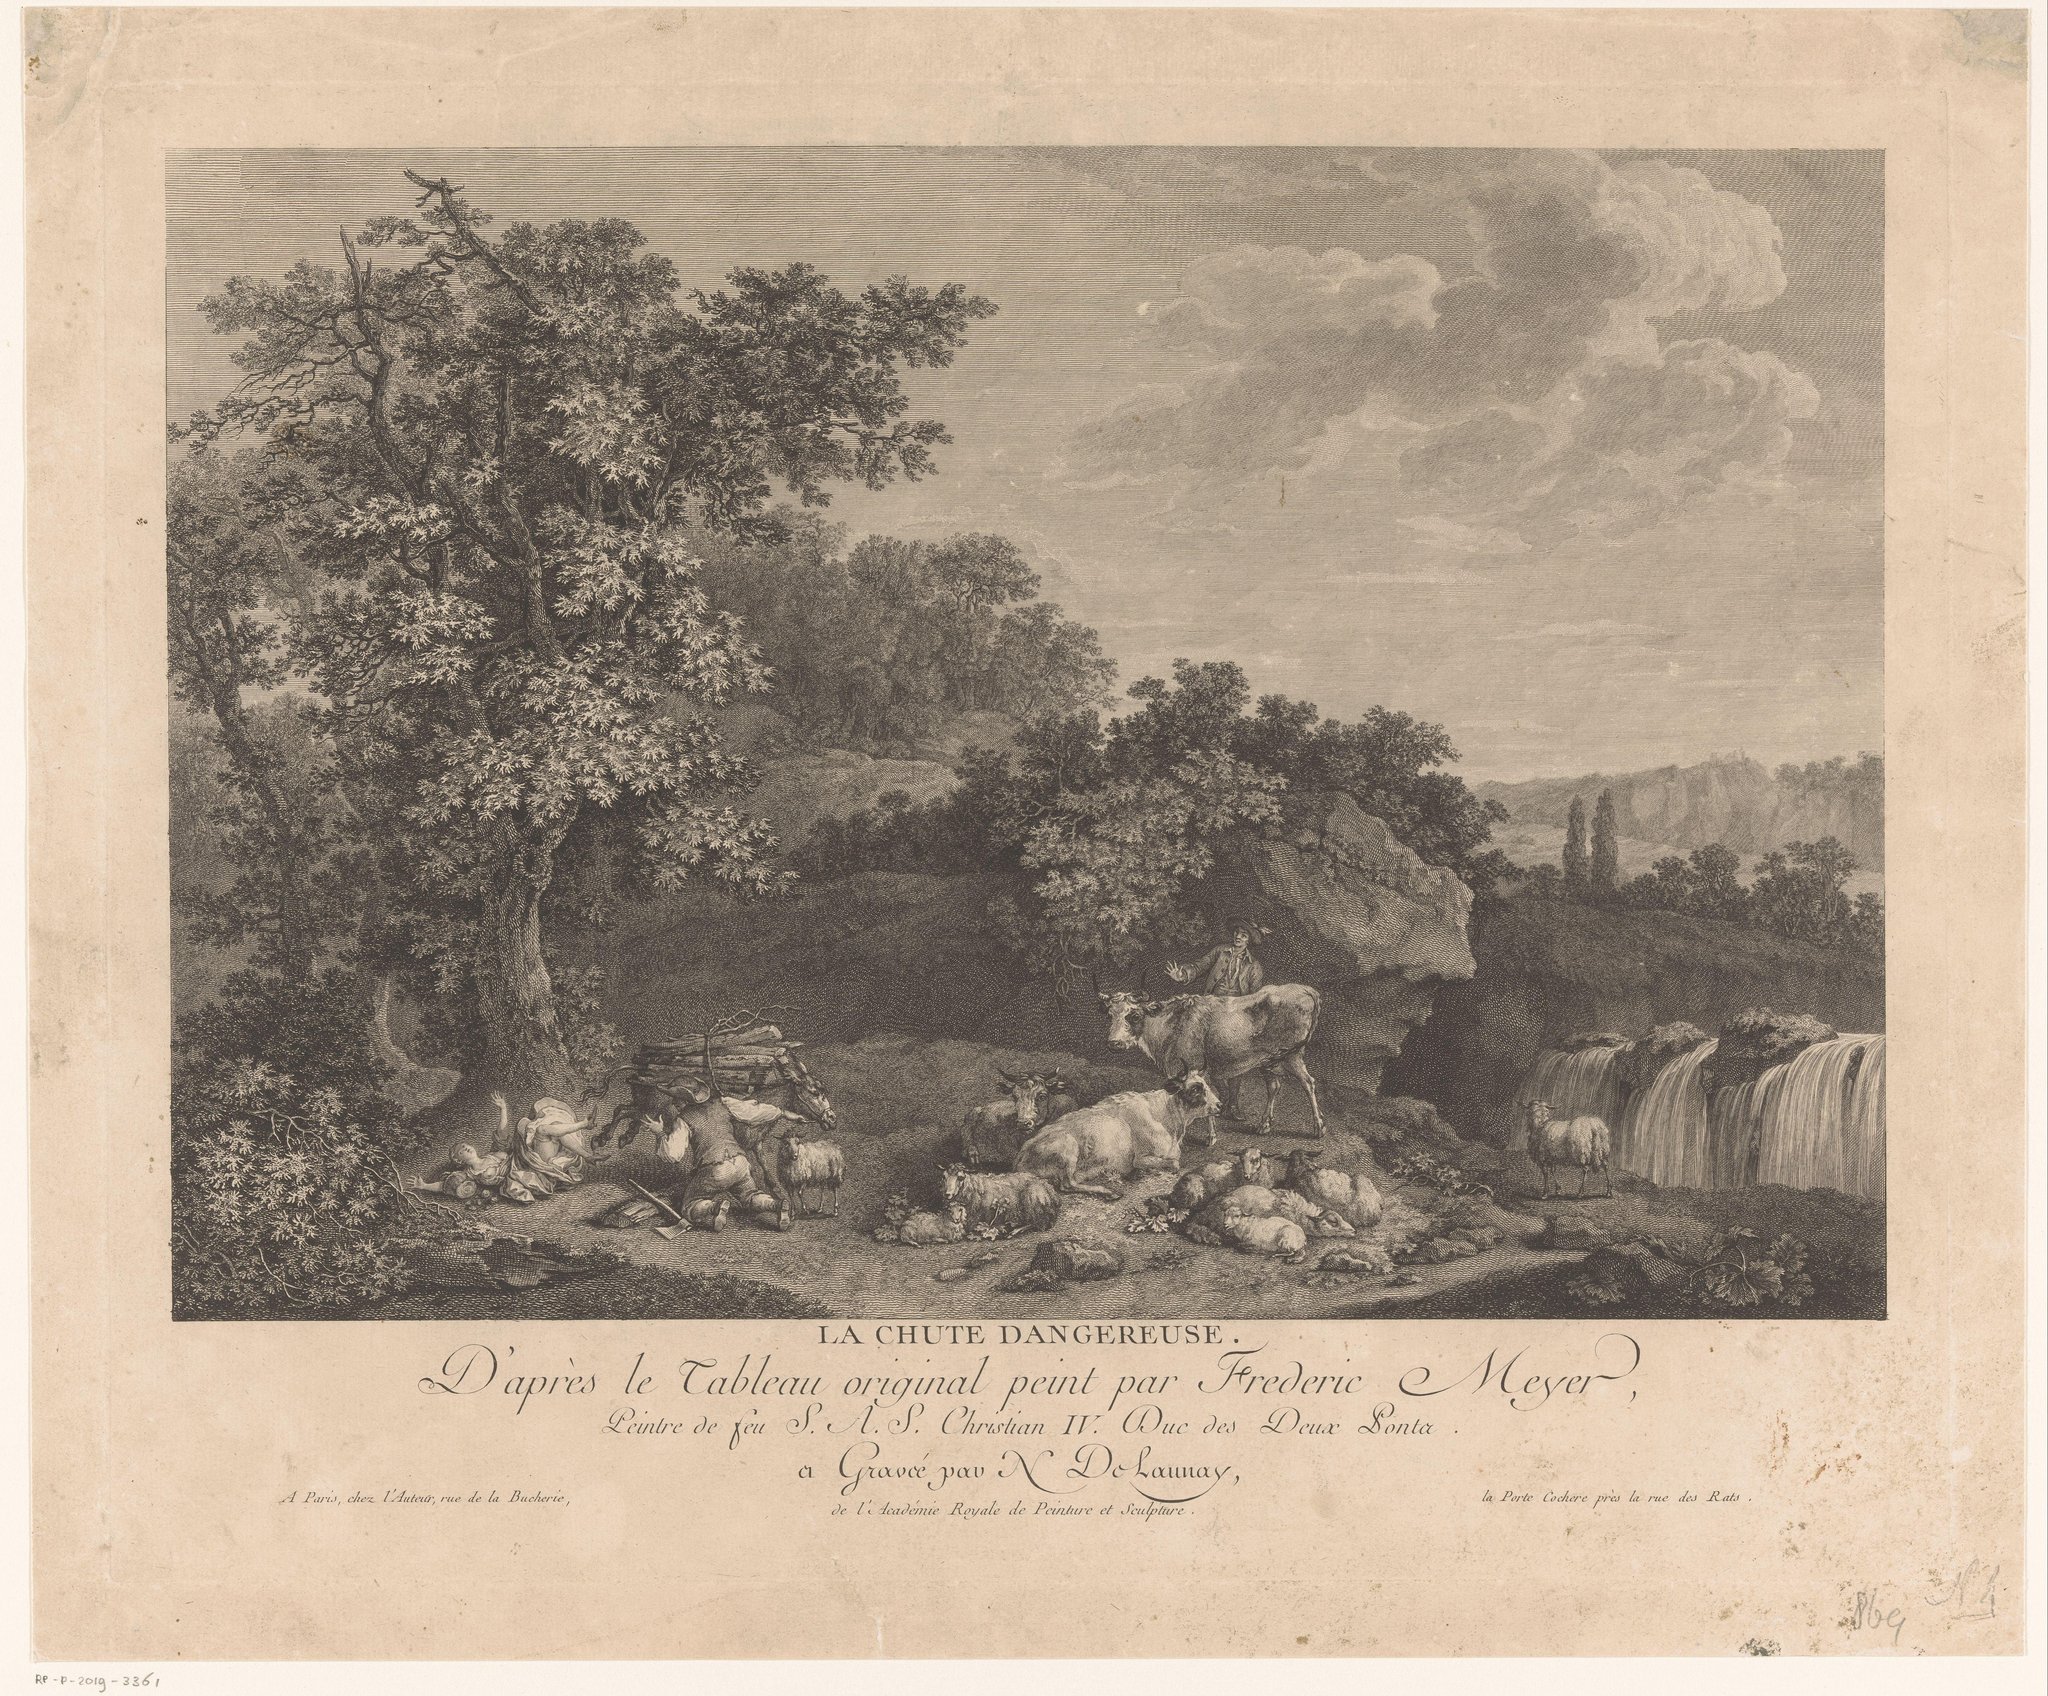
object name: print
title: La chute dangereuse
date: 1777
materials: paper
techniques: engraving, etching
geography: paris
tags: ass, donkey, waterfall, falling, herd, flock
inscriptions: collector's mark: Lugt 2028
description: Herders bij een waterval met links een vallende herderin bij een bokkende ezel.